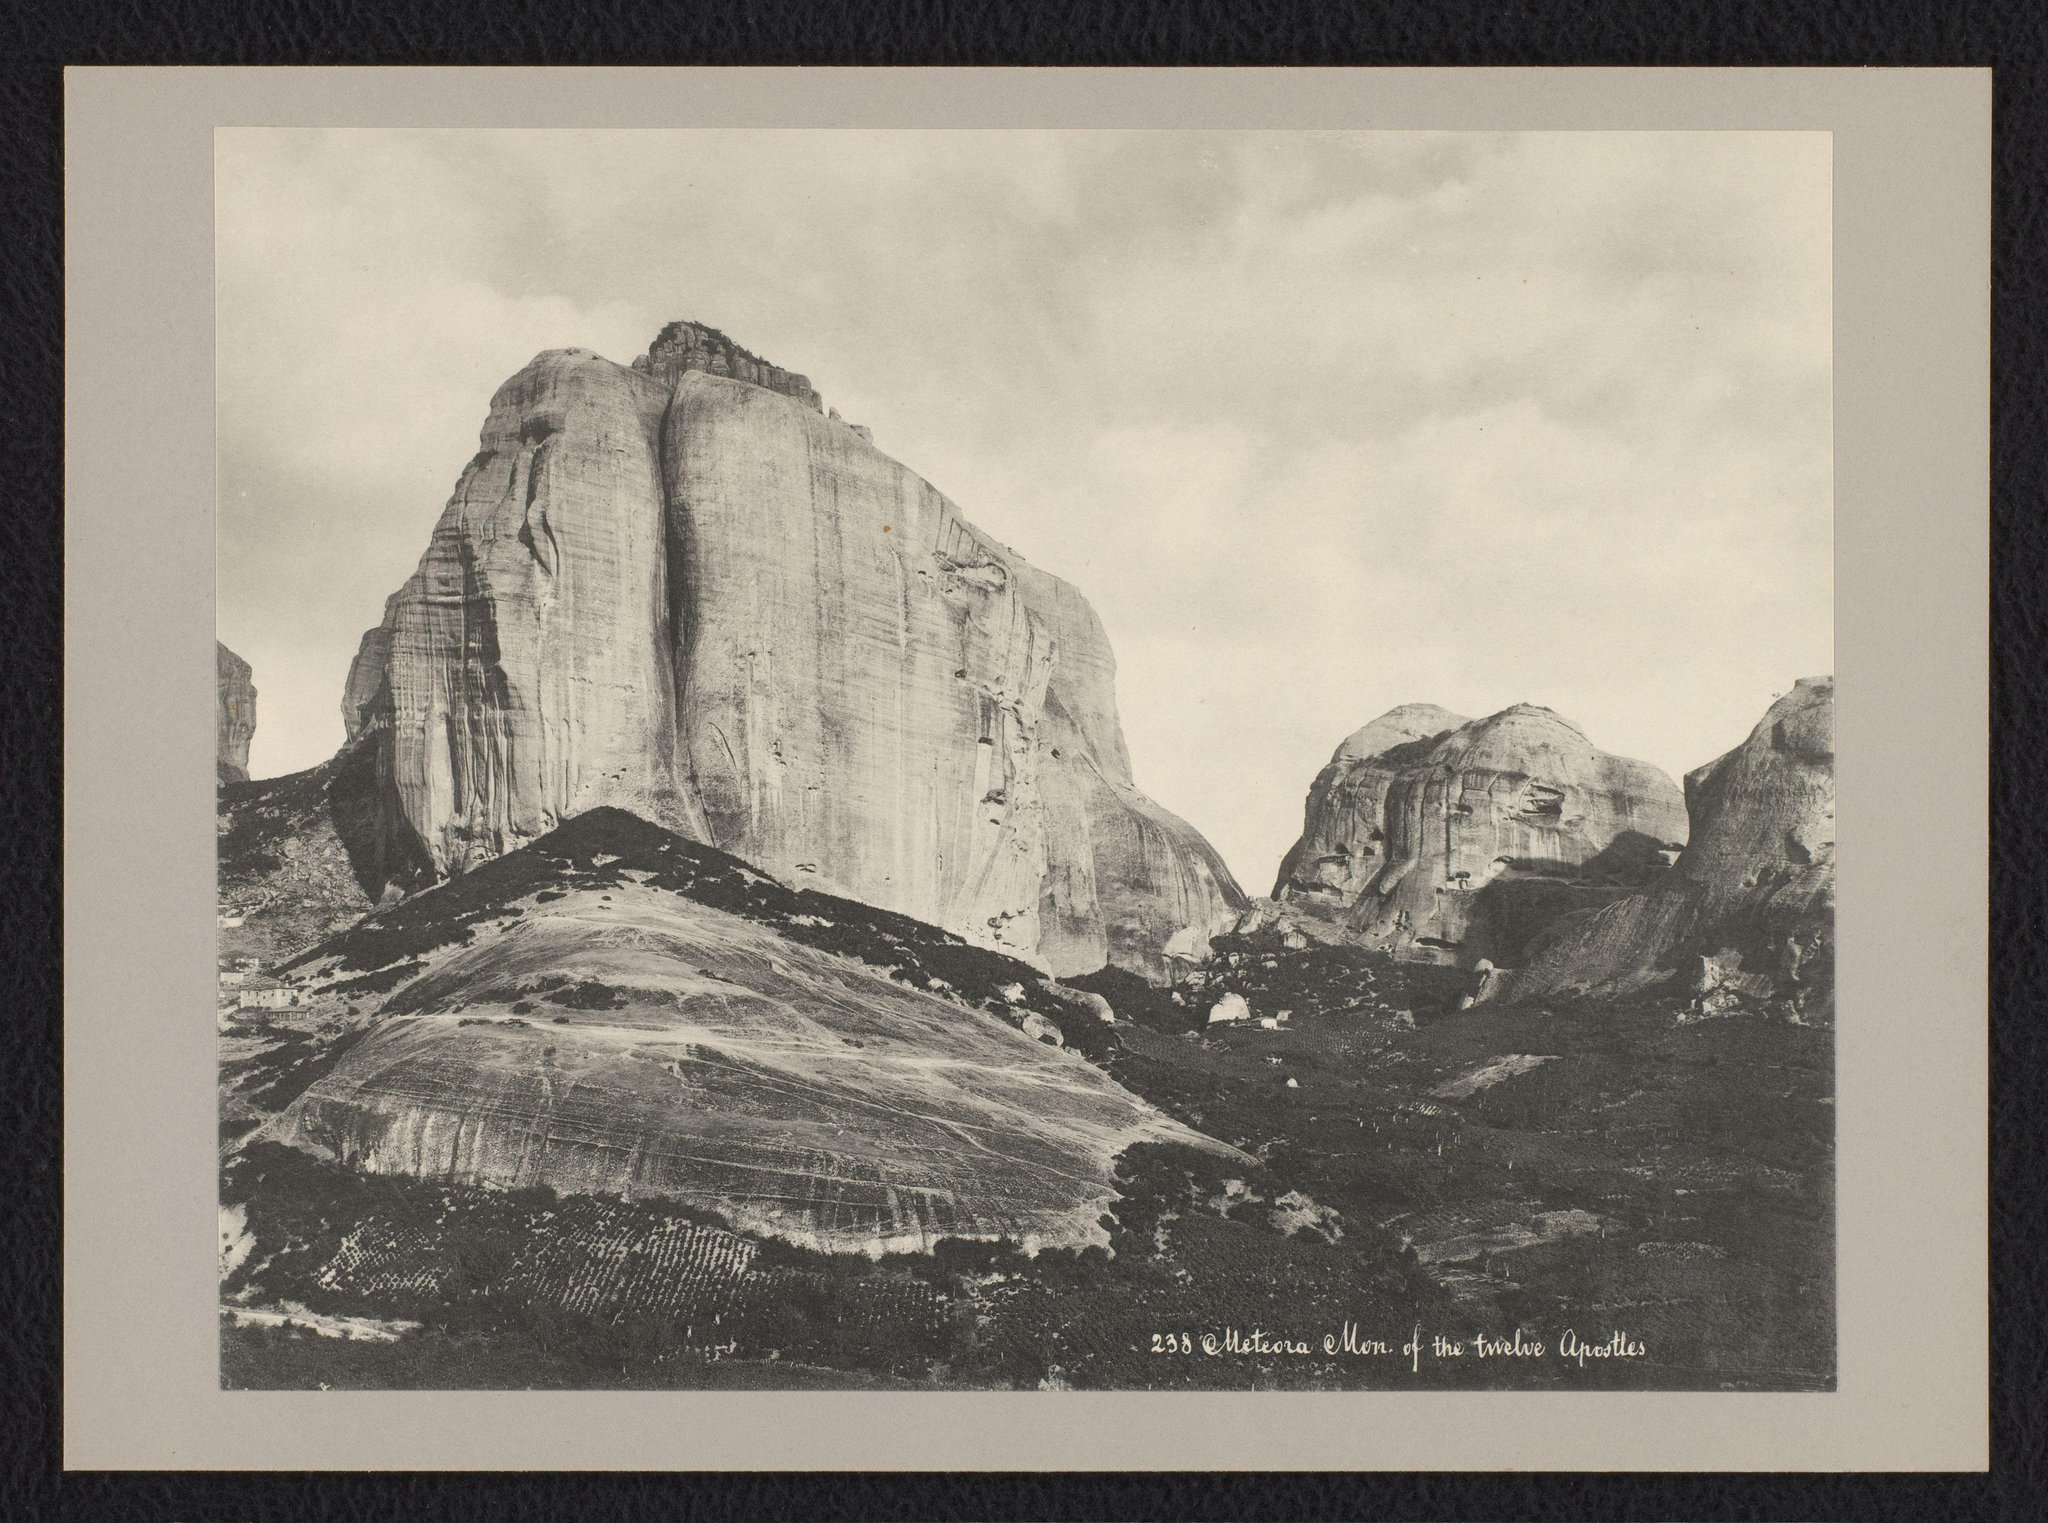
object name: photograph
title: 238 Meteora Mon. of the twelve Apostles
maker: Anonymous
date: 1895-1915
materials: cardboard, paper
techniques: photograph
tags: thessalië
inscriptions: number: ‘46.’